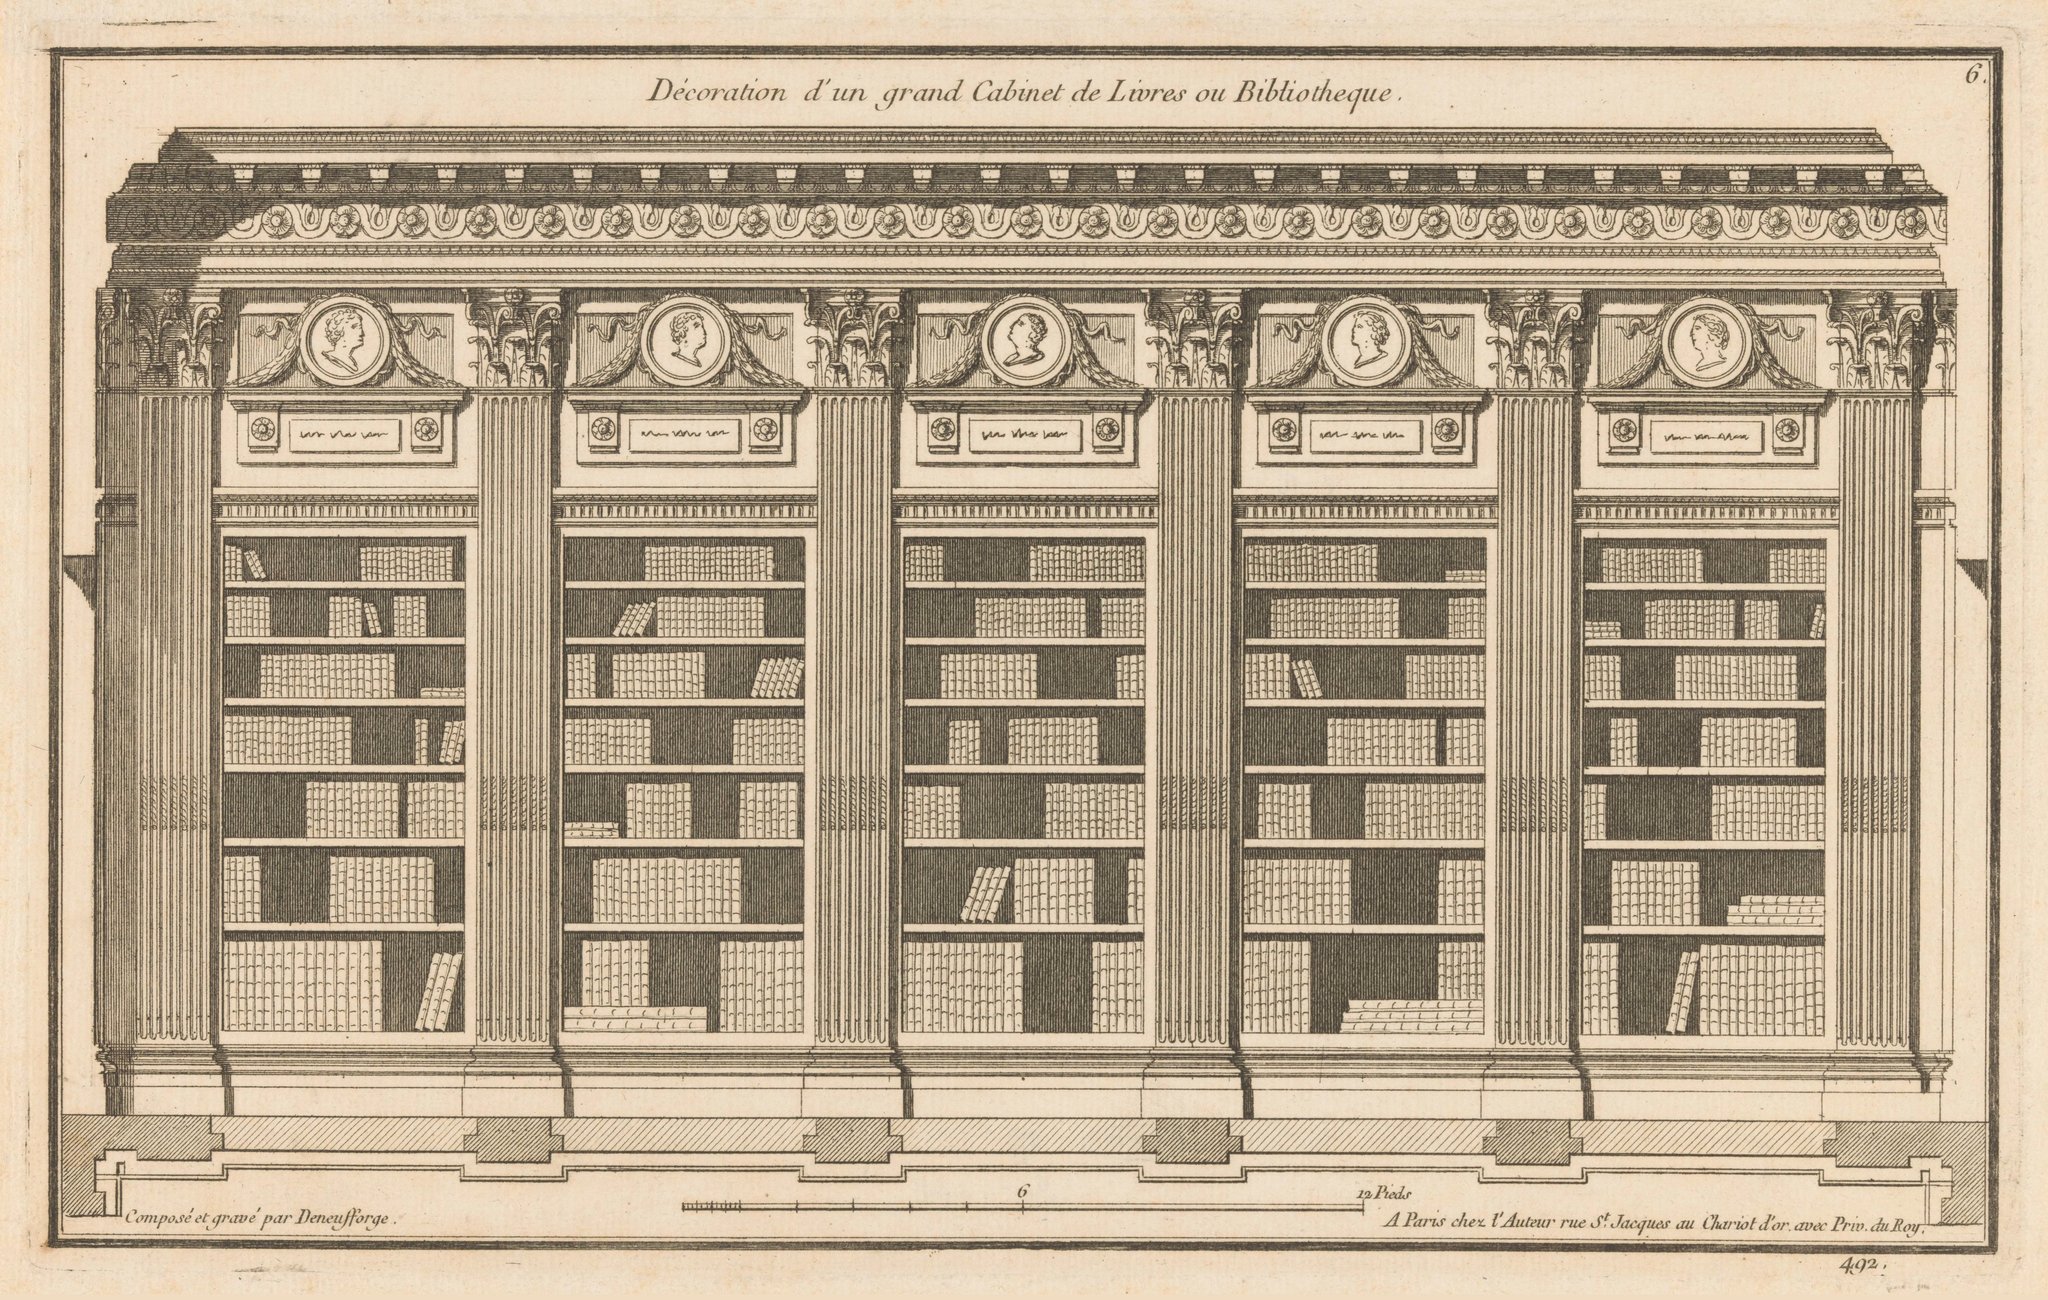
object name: print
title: Bibliotheek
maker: jean françois de neufforge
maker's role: print maker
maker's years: 1714-1791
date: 1767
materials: paper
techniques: etching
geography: paris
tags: study; 'studiolo'; library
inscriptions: collector's mark: Lugt 2760, collector's mark: Lugt 2228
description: Een bibliotheek met pilasters en vijf gevulde boekenkasten. Boven de kasten ronde medaillons met portretten. Prentnummer 492.